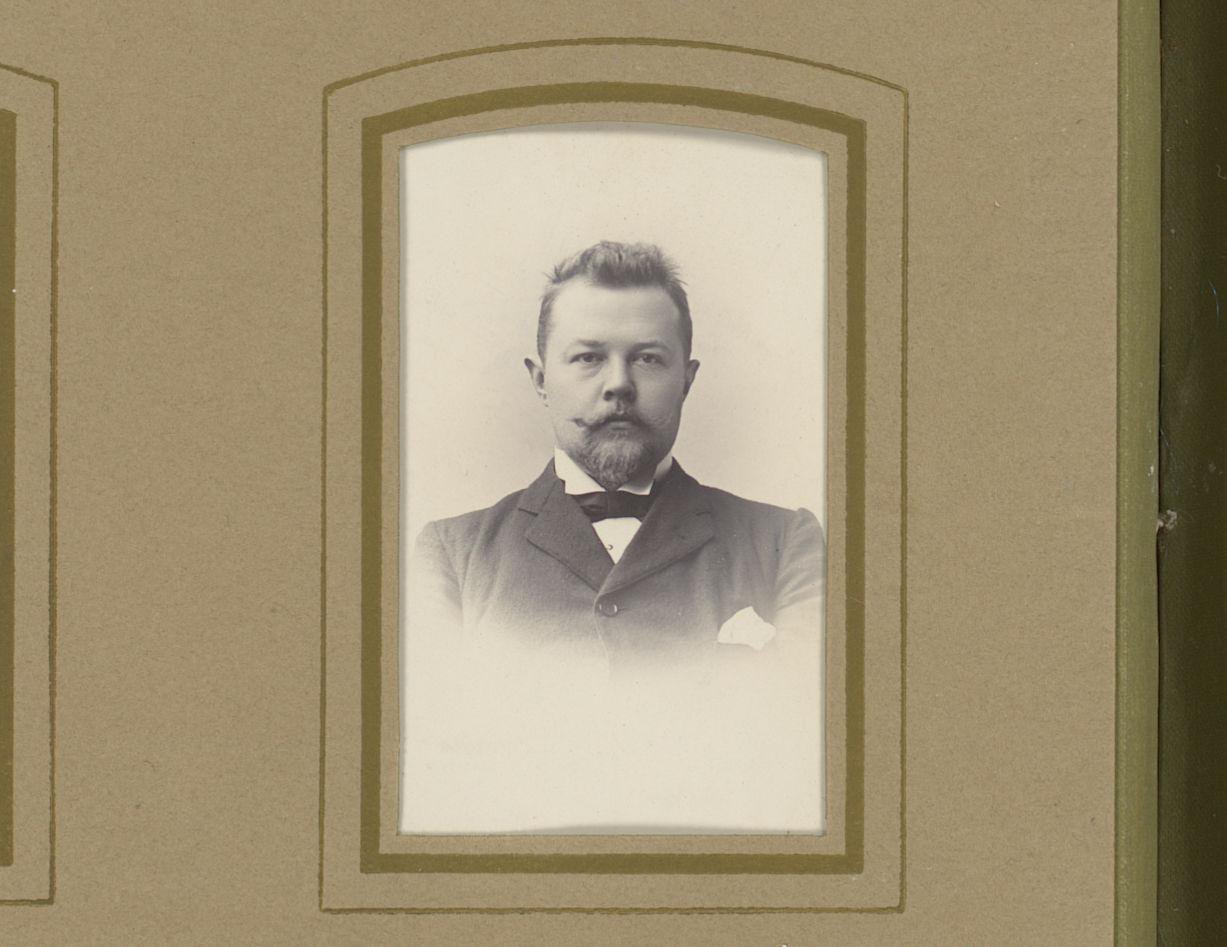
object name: photograph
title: Portret van een man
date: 1894-1907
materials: cardboard, photographic support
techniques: matte daylight collodion silver print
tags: historical persons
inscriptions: annotation: ‘Souvenir van/ [.].J. Mang[a]ms/ Febr. 1898.’, inscription: ‘Koene & Büttinghausen/ Amsterdam/ Heerengracht 150./ Telephoonnummer 1402./ Batavia.’